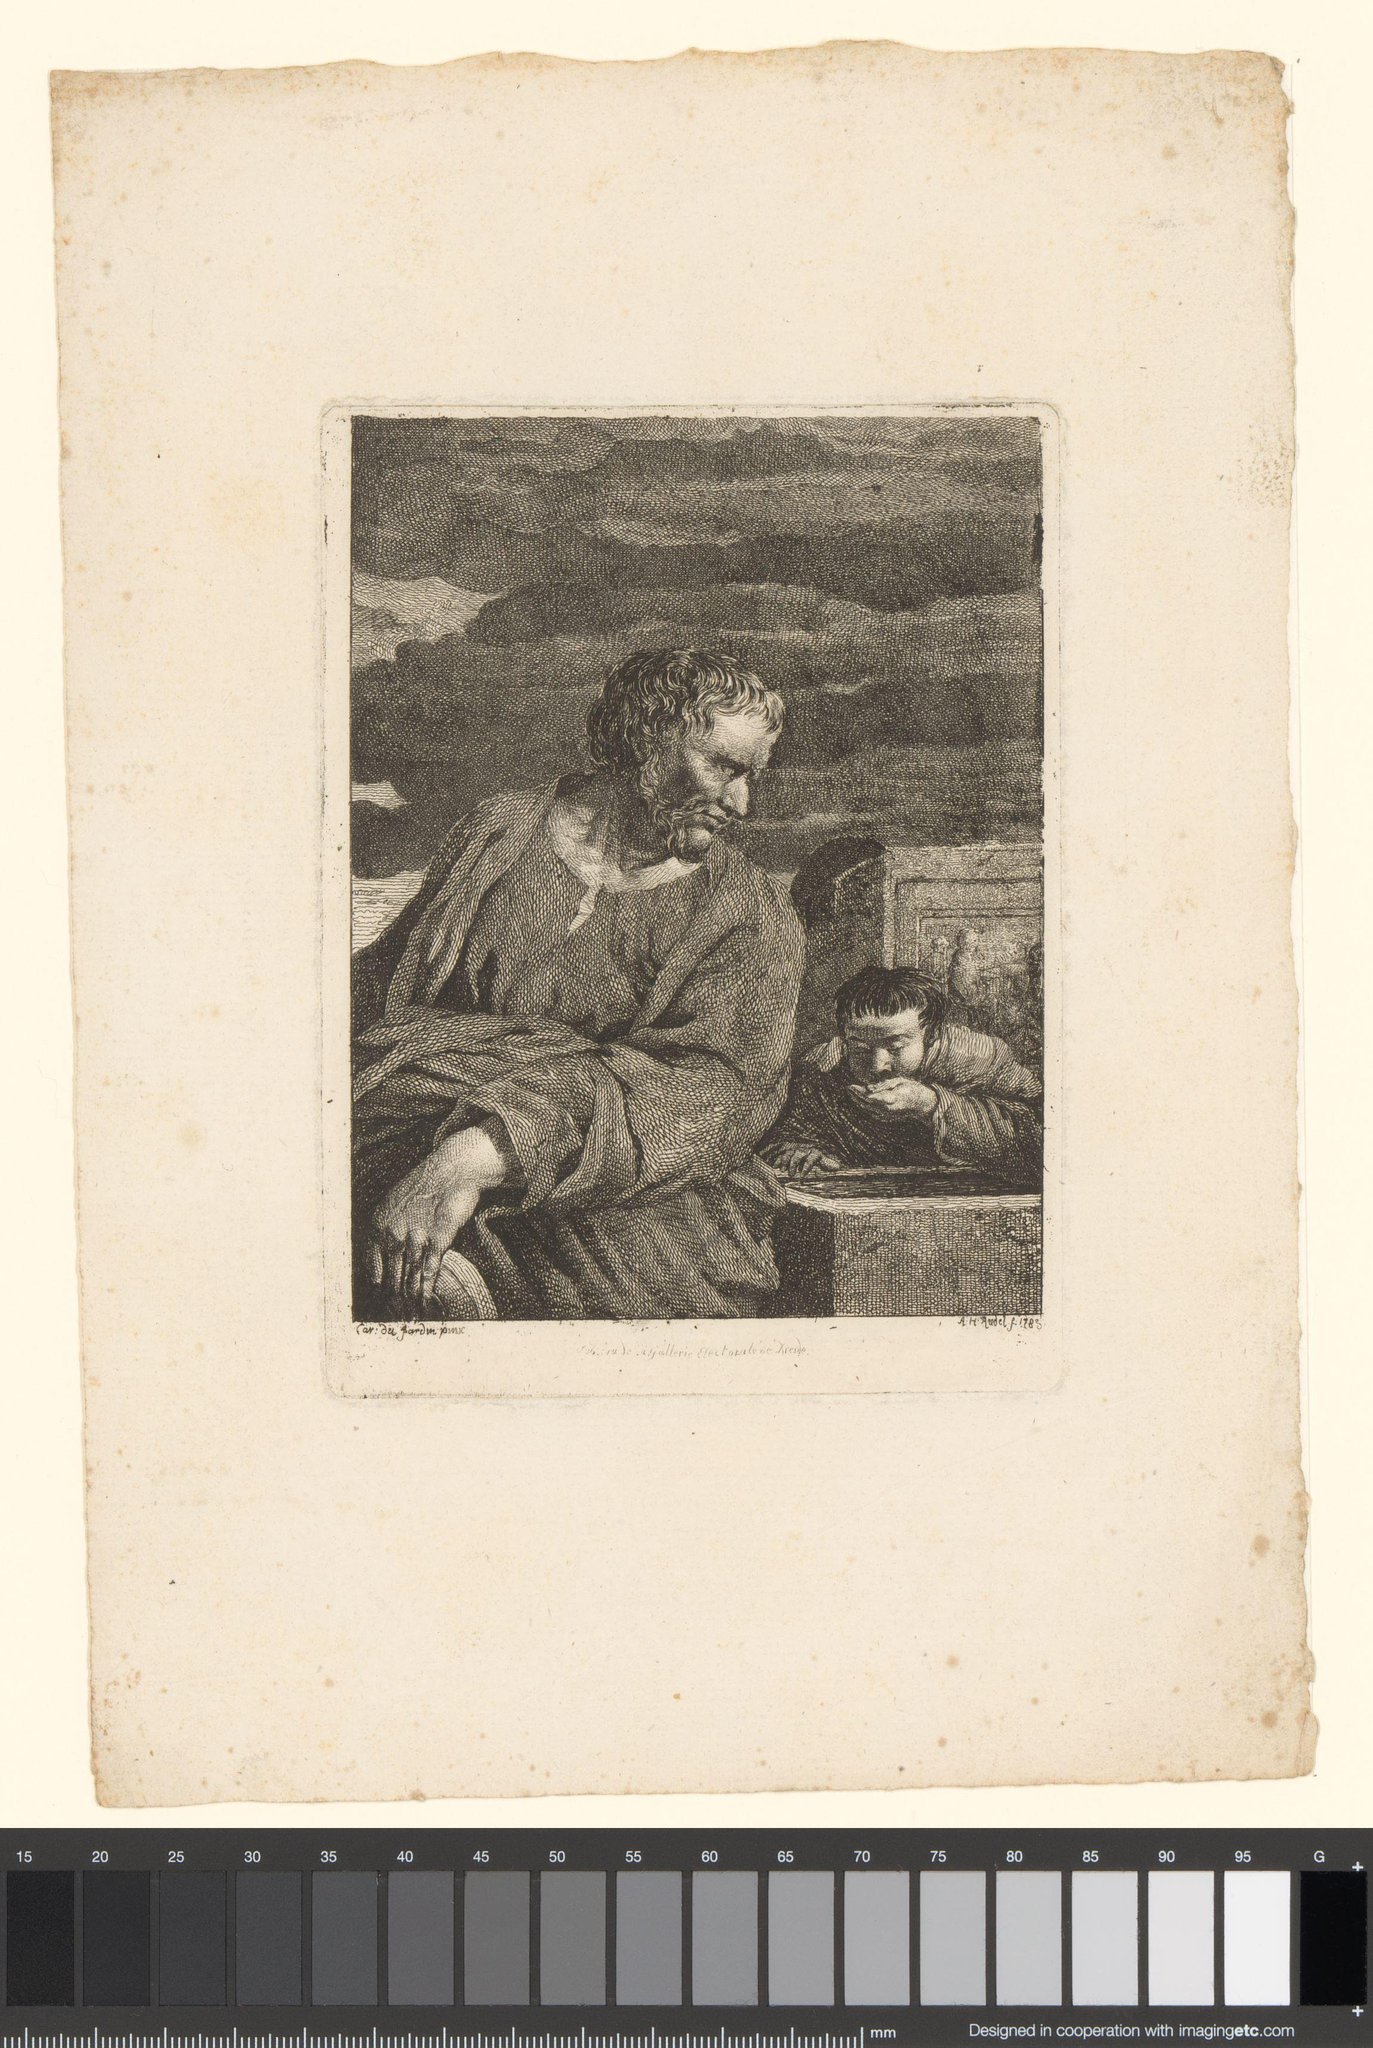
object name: print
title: Diogenes sees a boy drinking from his cupped hands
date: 1785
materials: paper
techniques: etching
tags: well, diogenes throws away his drinking-cup on seeing a boy drink from his cupped hands, drinking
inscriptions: collector's mark: Lugt 2760, collector's mark: Lugt 2228